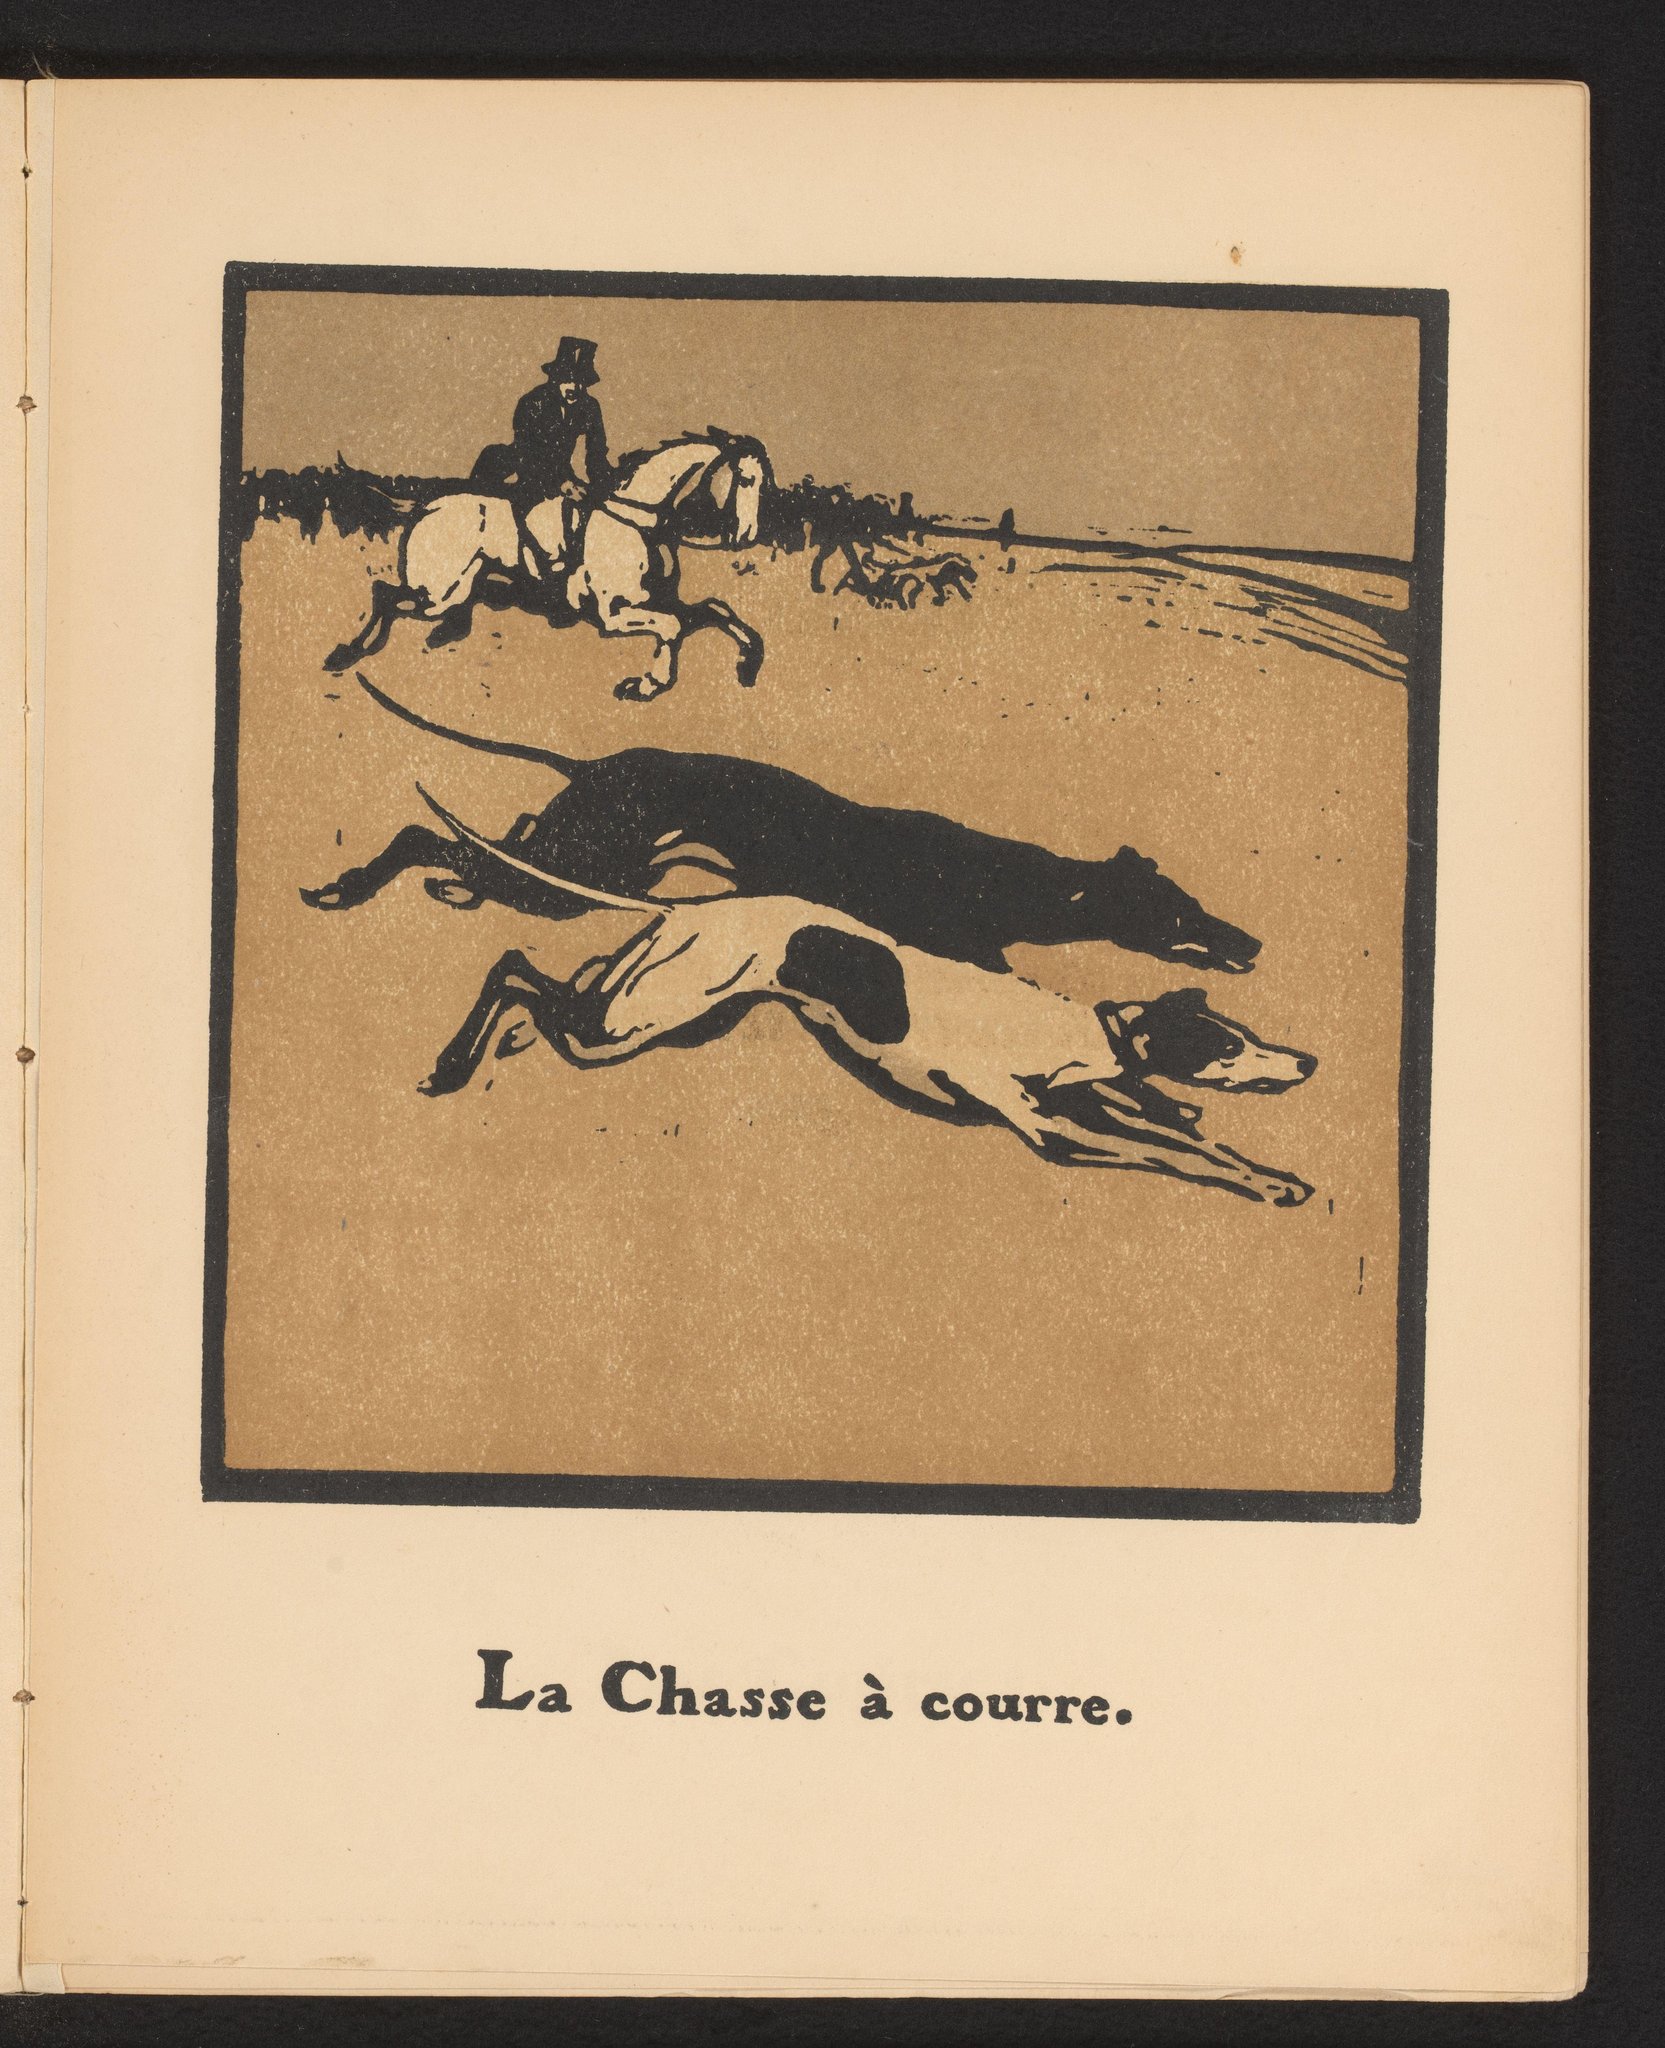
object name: print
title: Almanak met twaalf sporten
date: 1898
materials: paper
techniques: lithograph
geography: paris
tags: calendar, almanac, hunting dogs, jockey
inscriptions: : ‘Mars./ Dimanche - 6 13 20 27/ Lundi - 7 14 21 (...)’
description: Prent maakt deel uit van een boek. Illustratie bij kalendermaand op tegenoverliggende blad.